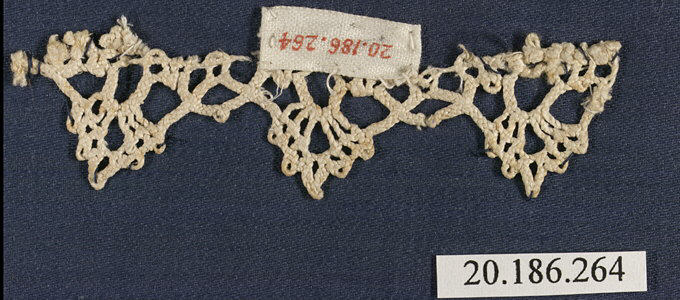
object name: edging fragment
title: Fragment of edging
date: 1501-1600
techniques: lace